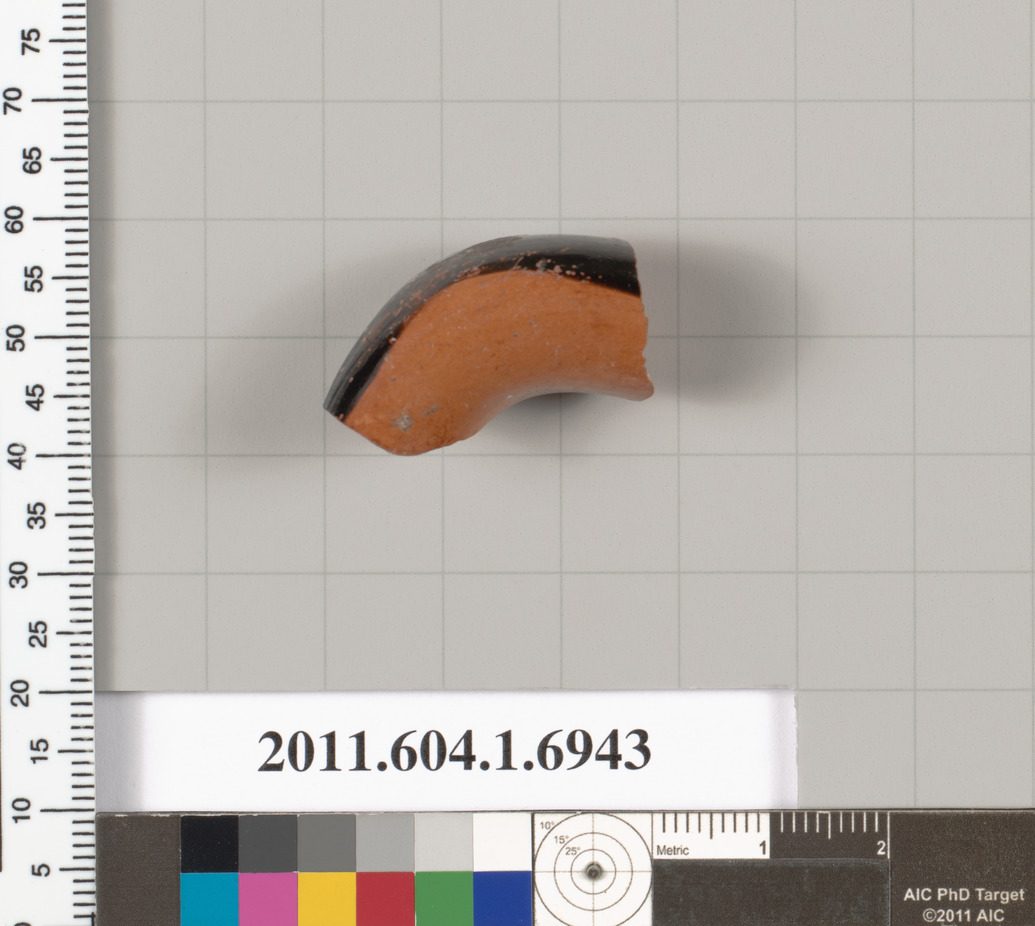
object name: kylix fragment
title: Terracotta fragment of a kylix (drinking cup)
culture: greek, attic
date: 490-470 BCE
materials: terracotta